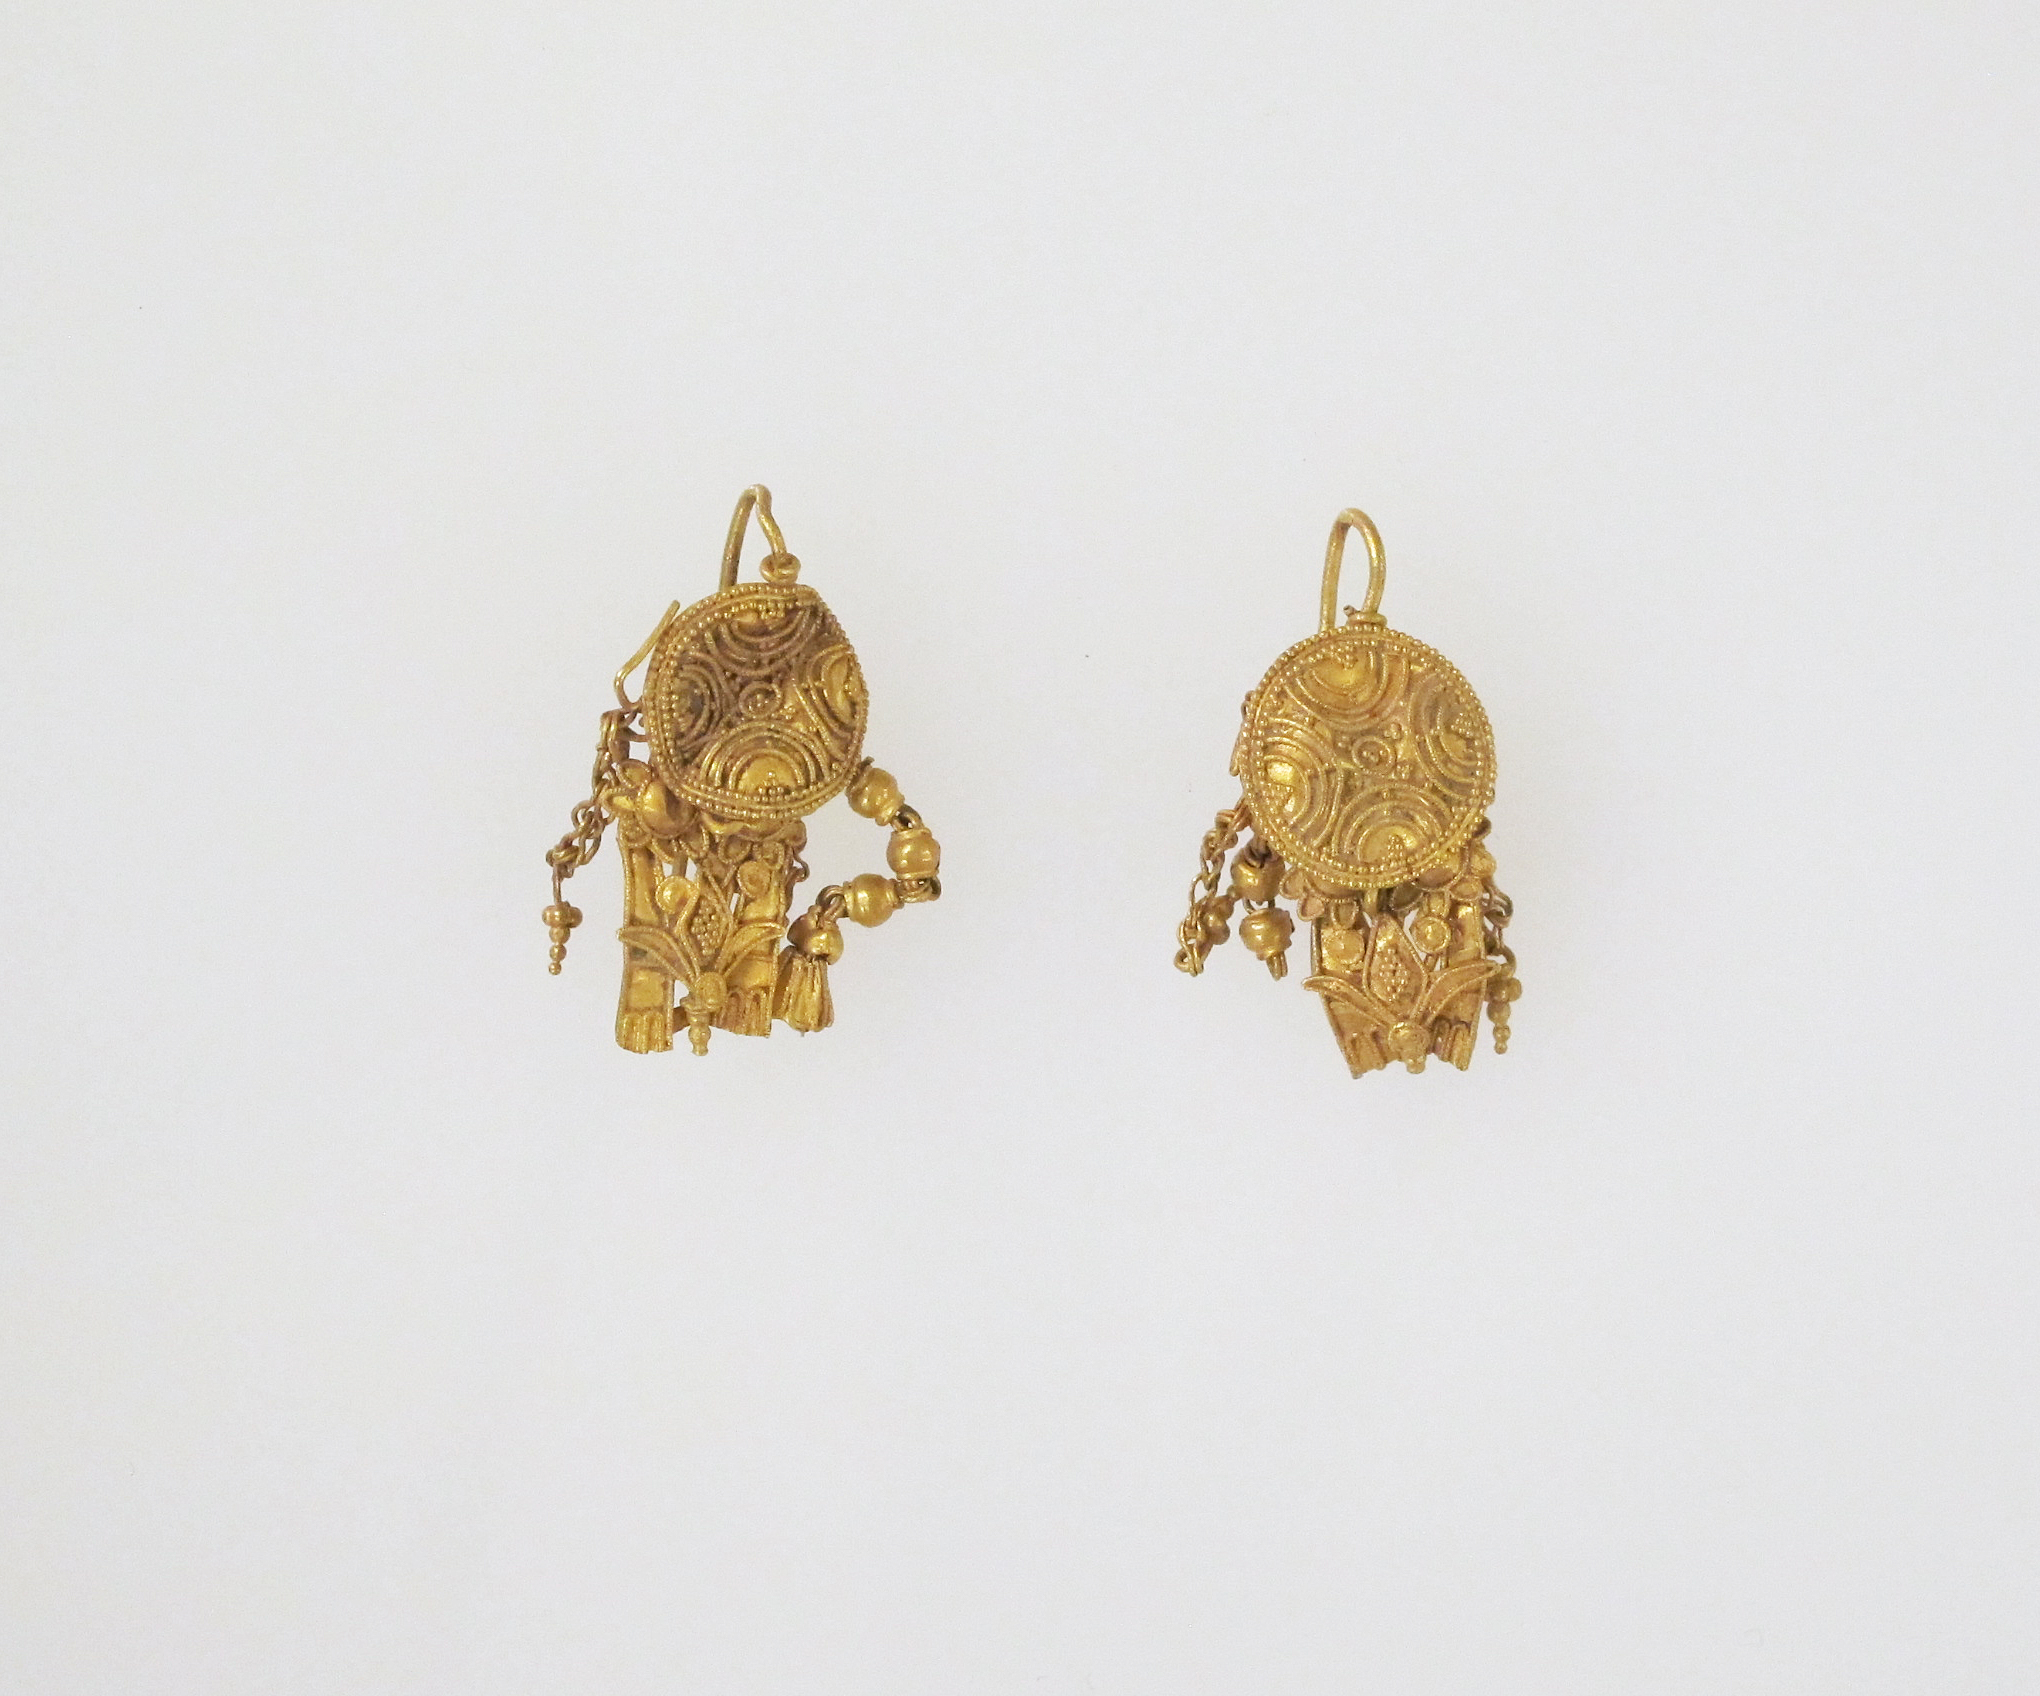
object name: earring with pendant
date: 400-201 BCE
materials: gold